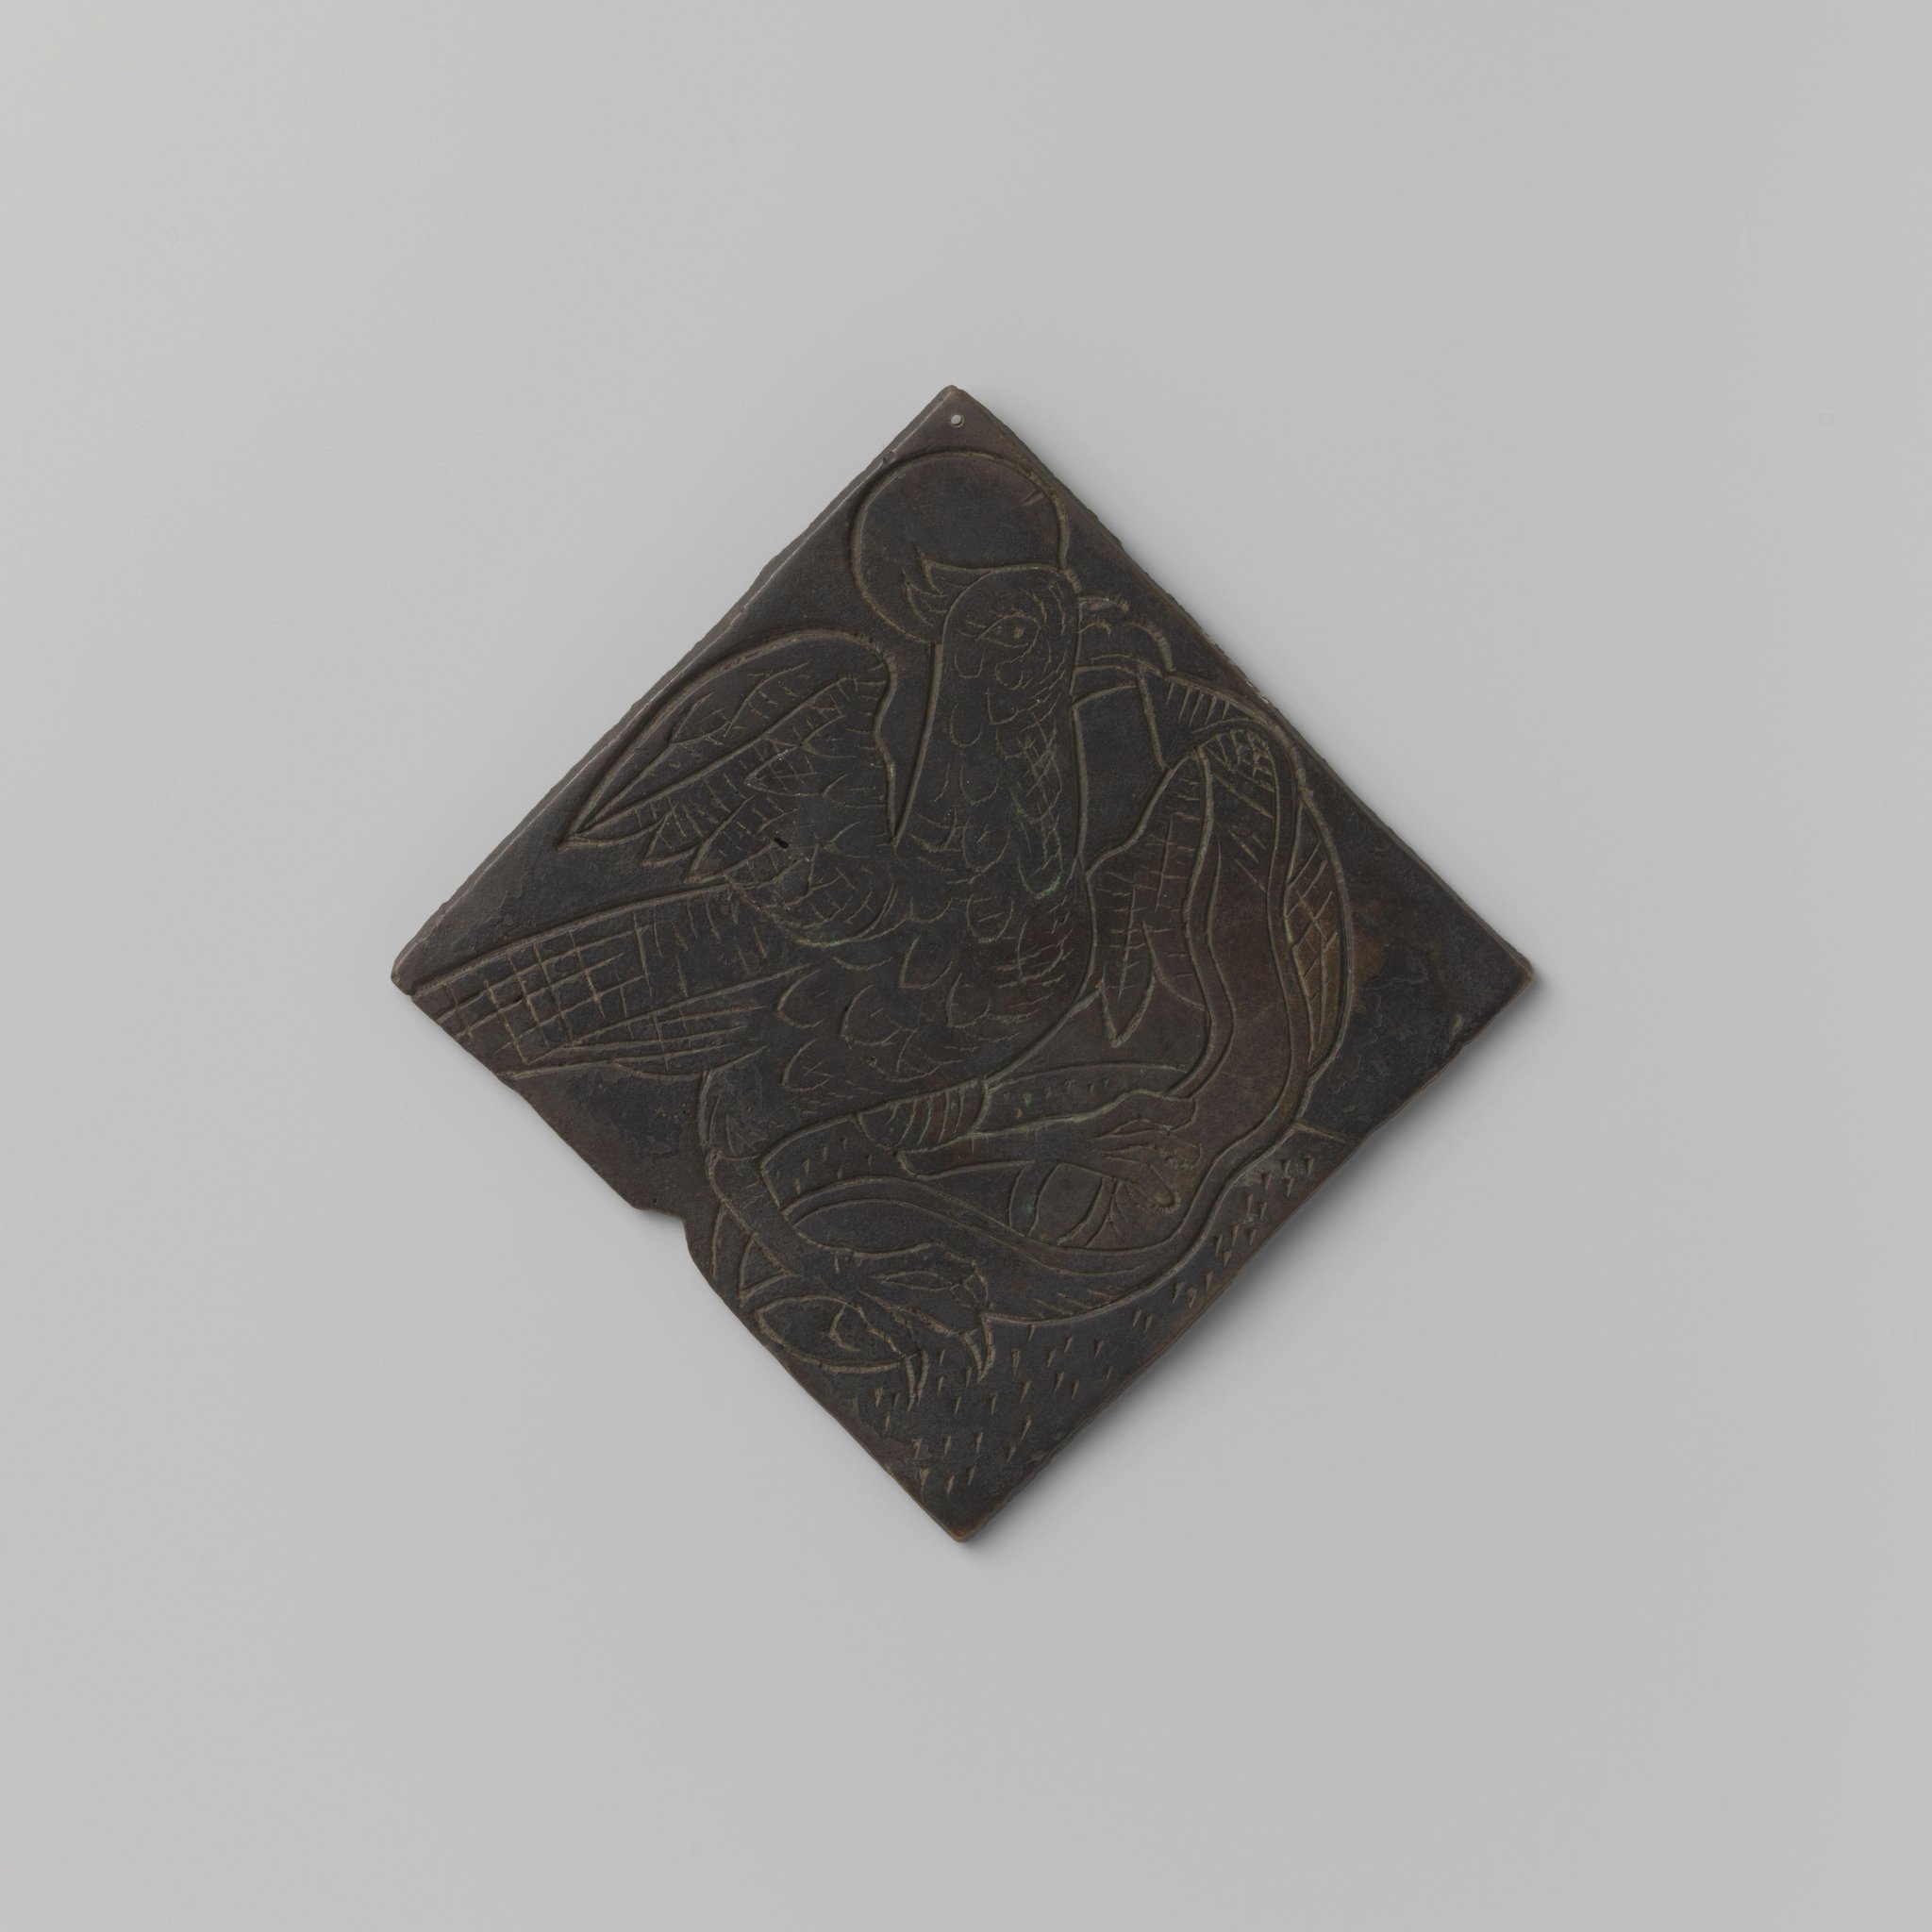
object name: plate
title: Plaat met het symbool van de evangelist Johannes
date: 1400-1500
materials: brass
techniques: engraving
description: De plaat heeft een gegraveerde voorstelling van een adelaar met een aureool om de kop. In de bek van het dier een banderol zonder inscriptie.